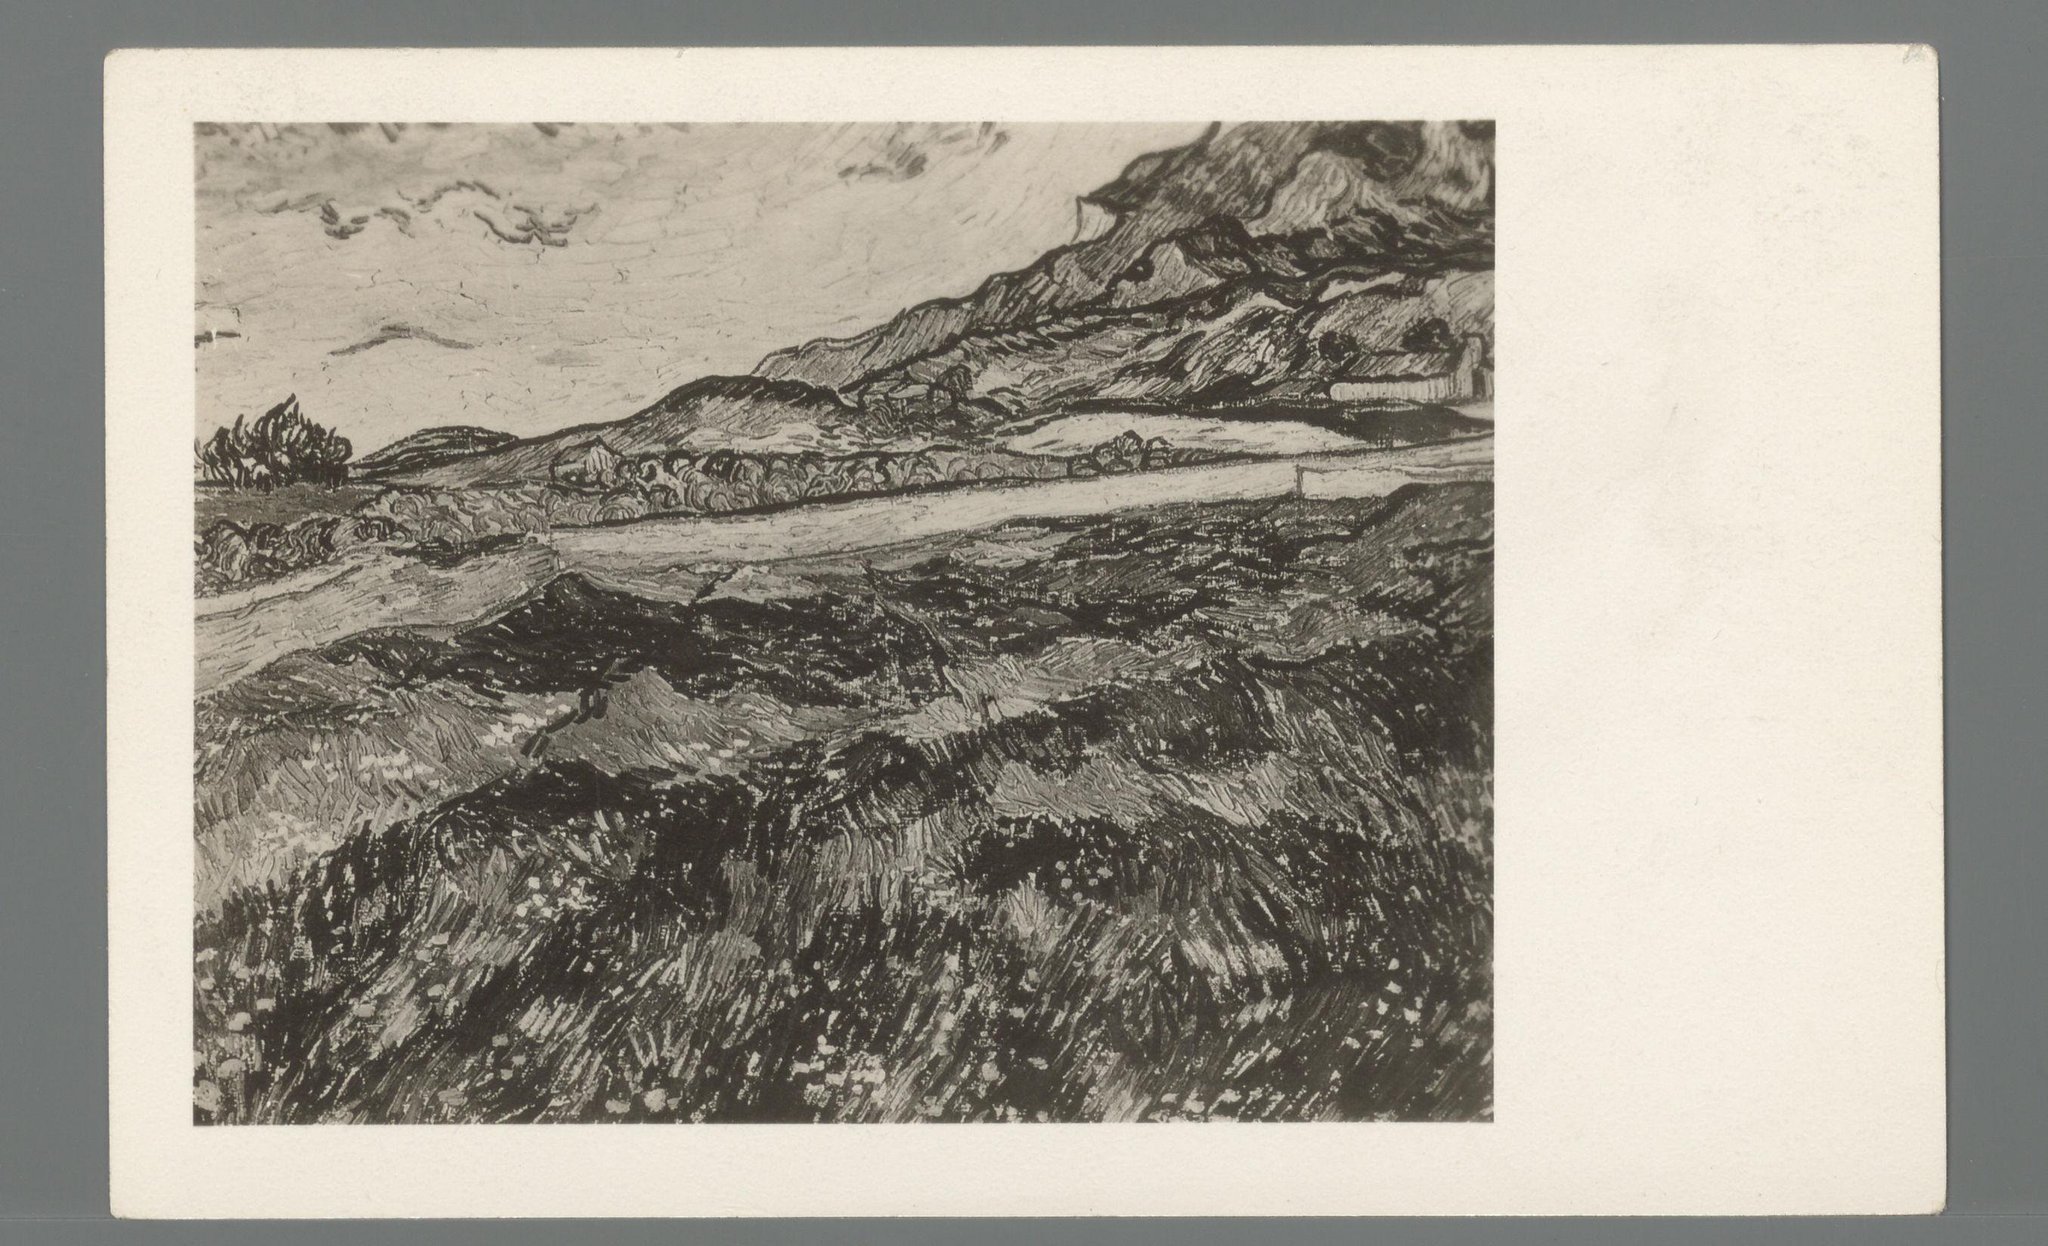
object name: photograph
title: Landscape (St. Remy)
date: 1936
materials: photographic support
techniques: photography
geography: cleveland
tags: low hill country